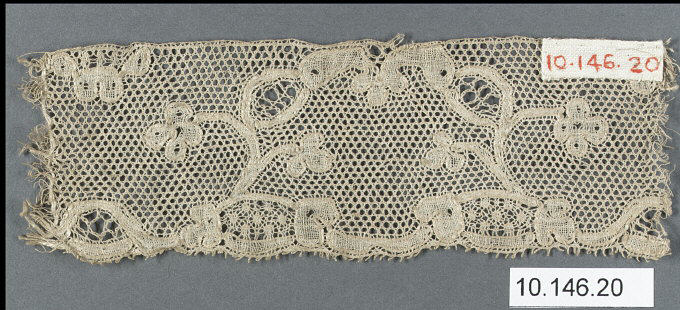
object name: fragment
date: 1701-1800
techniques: lace